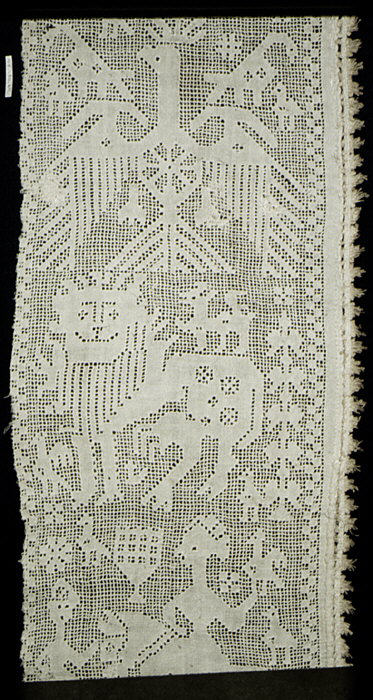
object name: fragment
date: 1501-1600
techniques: embroidery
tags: eagles,lions